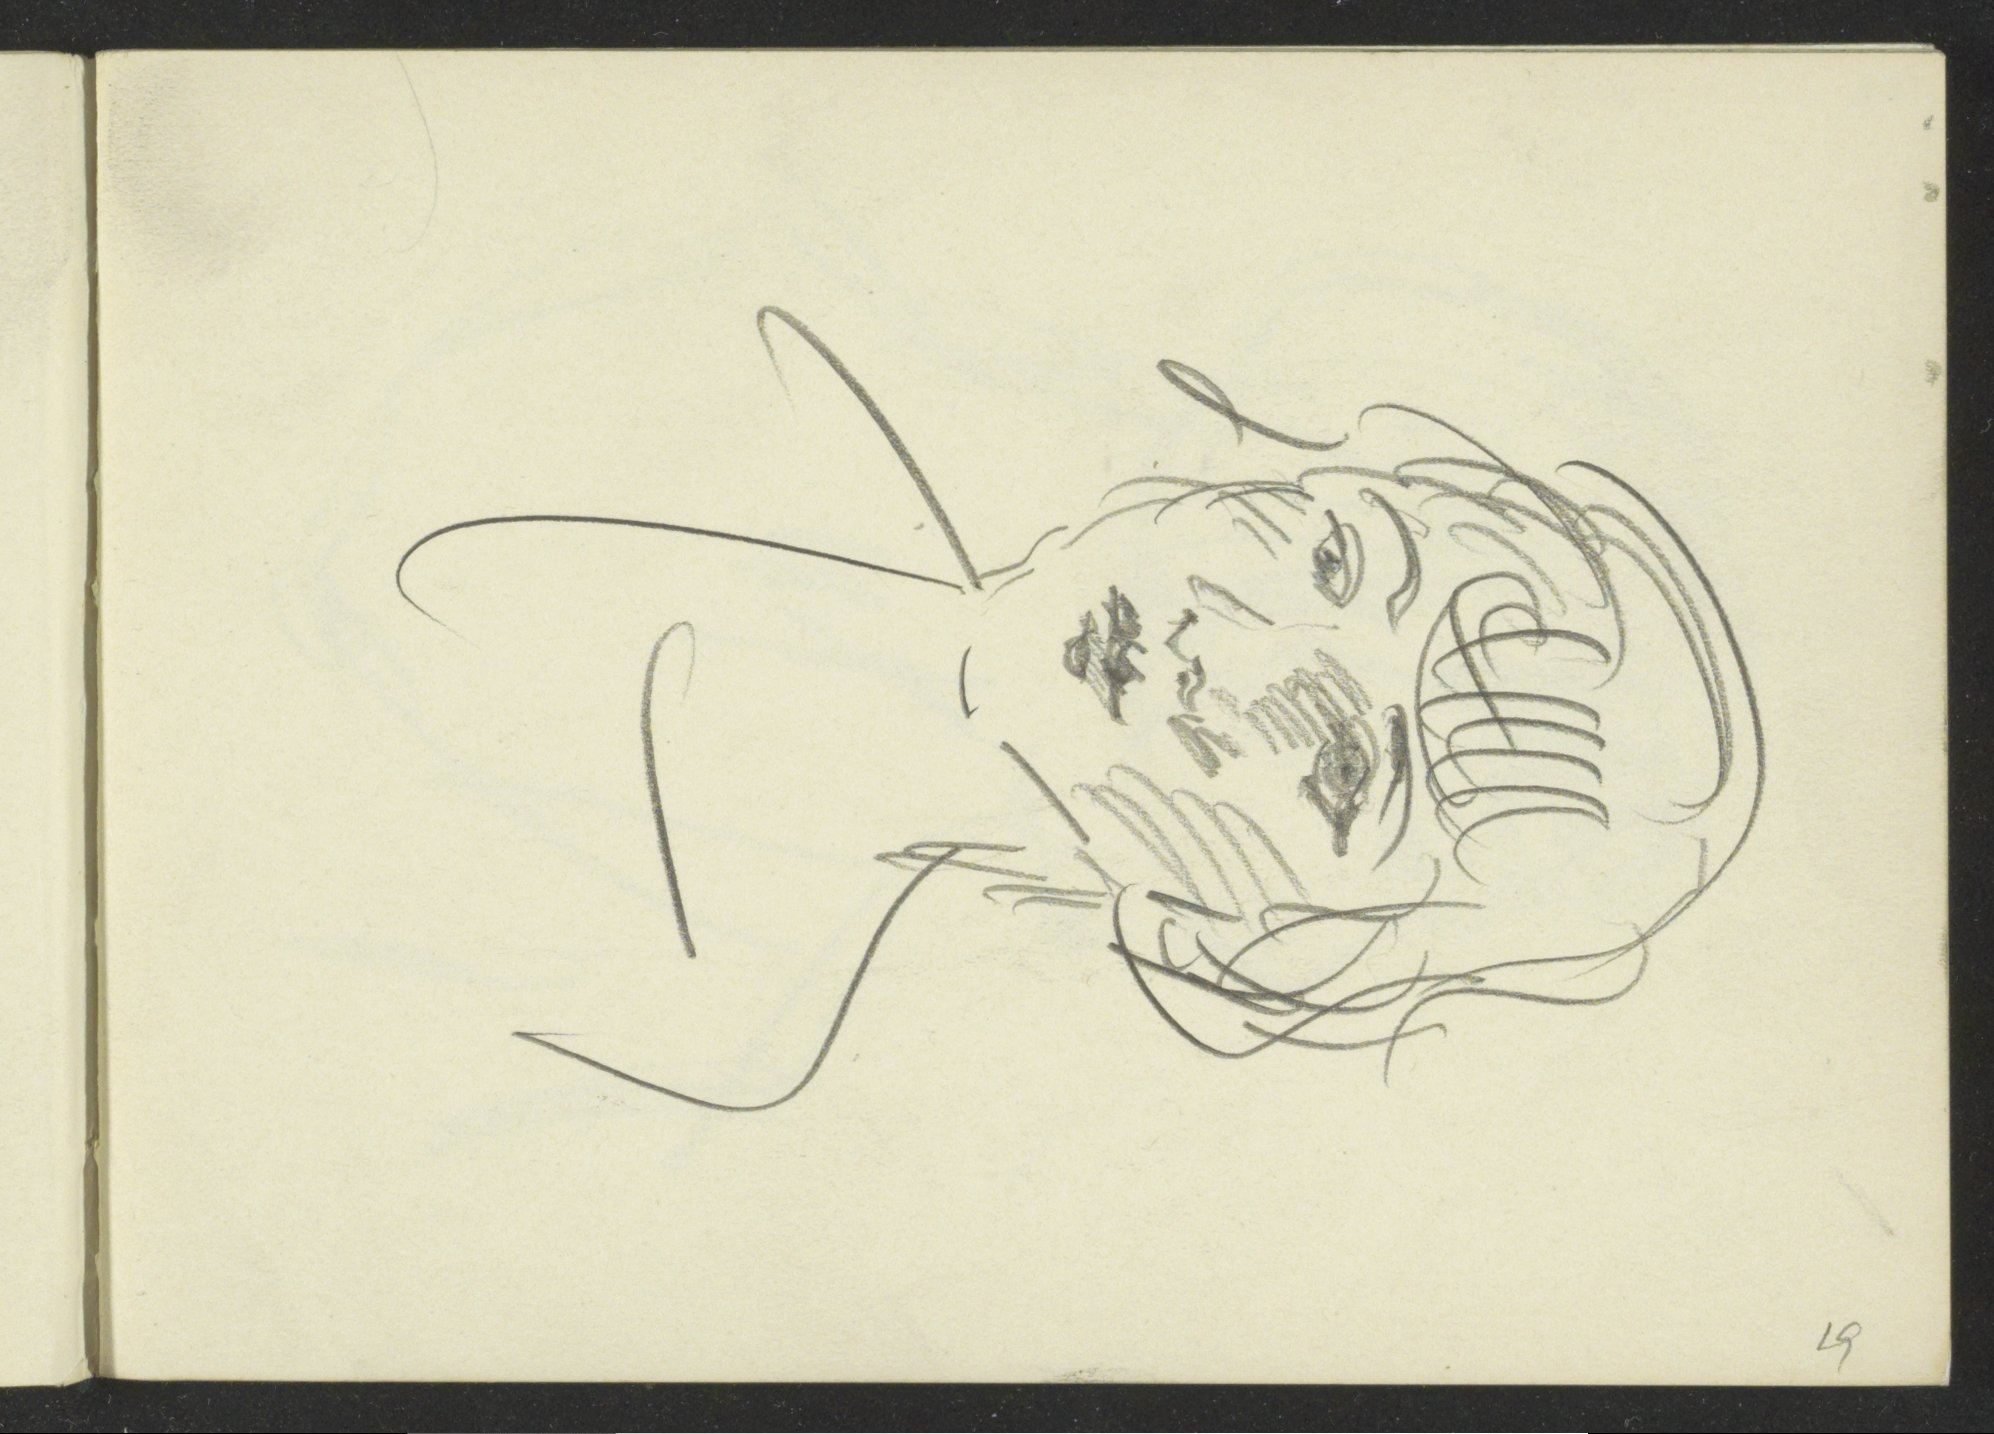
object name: sketchbook leaf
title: Vrouwenhoofd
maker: isaac israels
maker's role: draughtsman, painter, print maker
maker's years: 1865-1934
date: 1875-1934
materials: paper, pencil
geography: the hague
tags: head (human) - aa - female human figure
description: Blad 19 recto uit schetsboek LXV met 27 bladen.